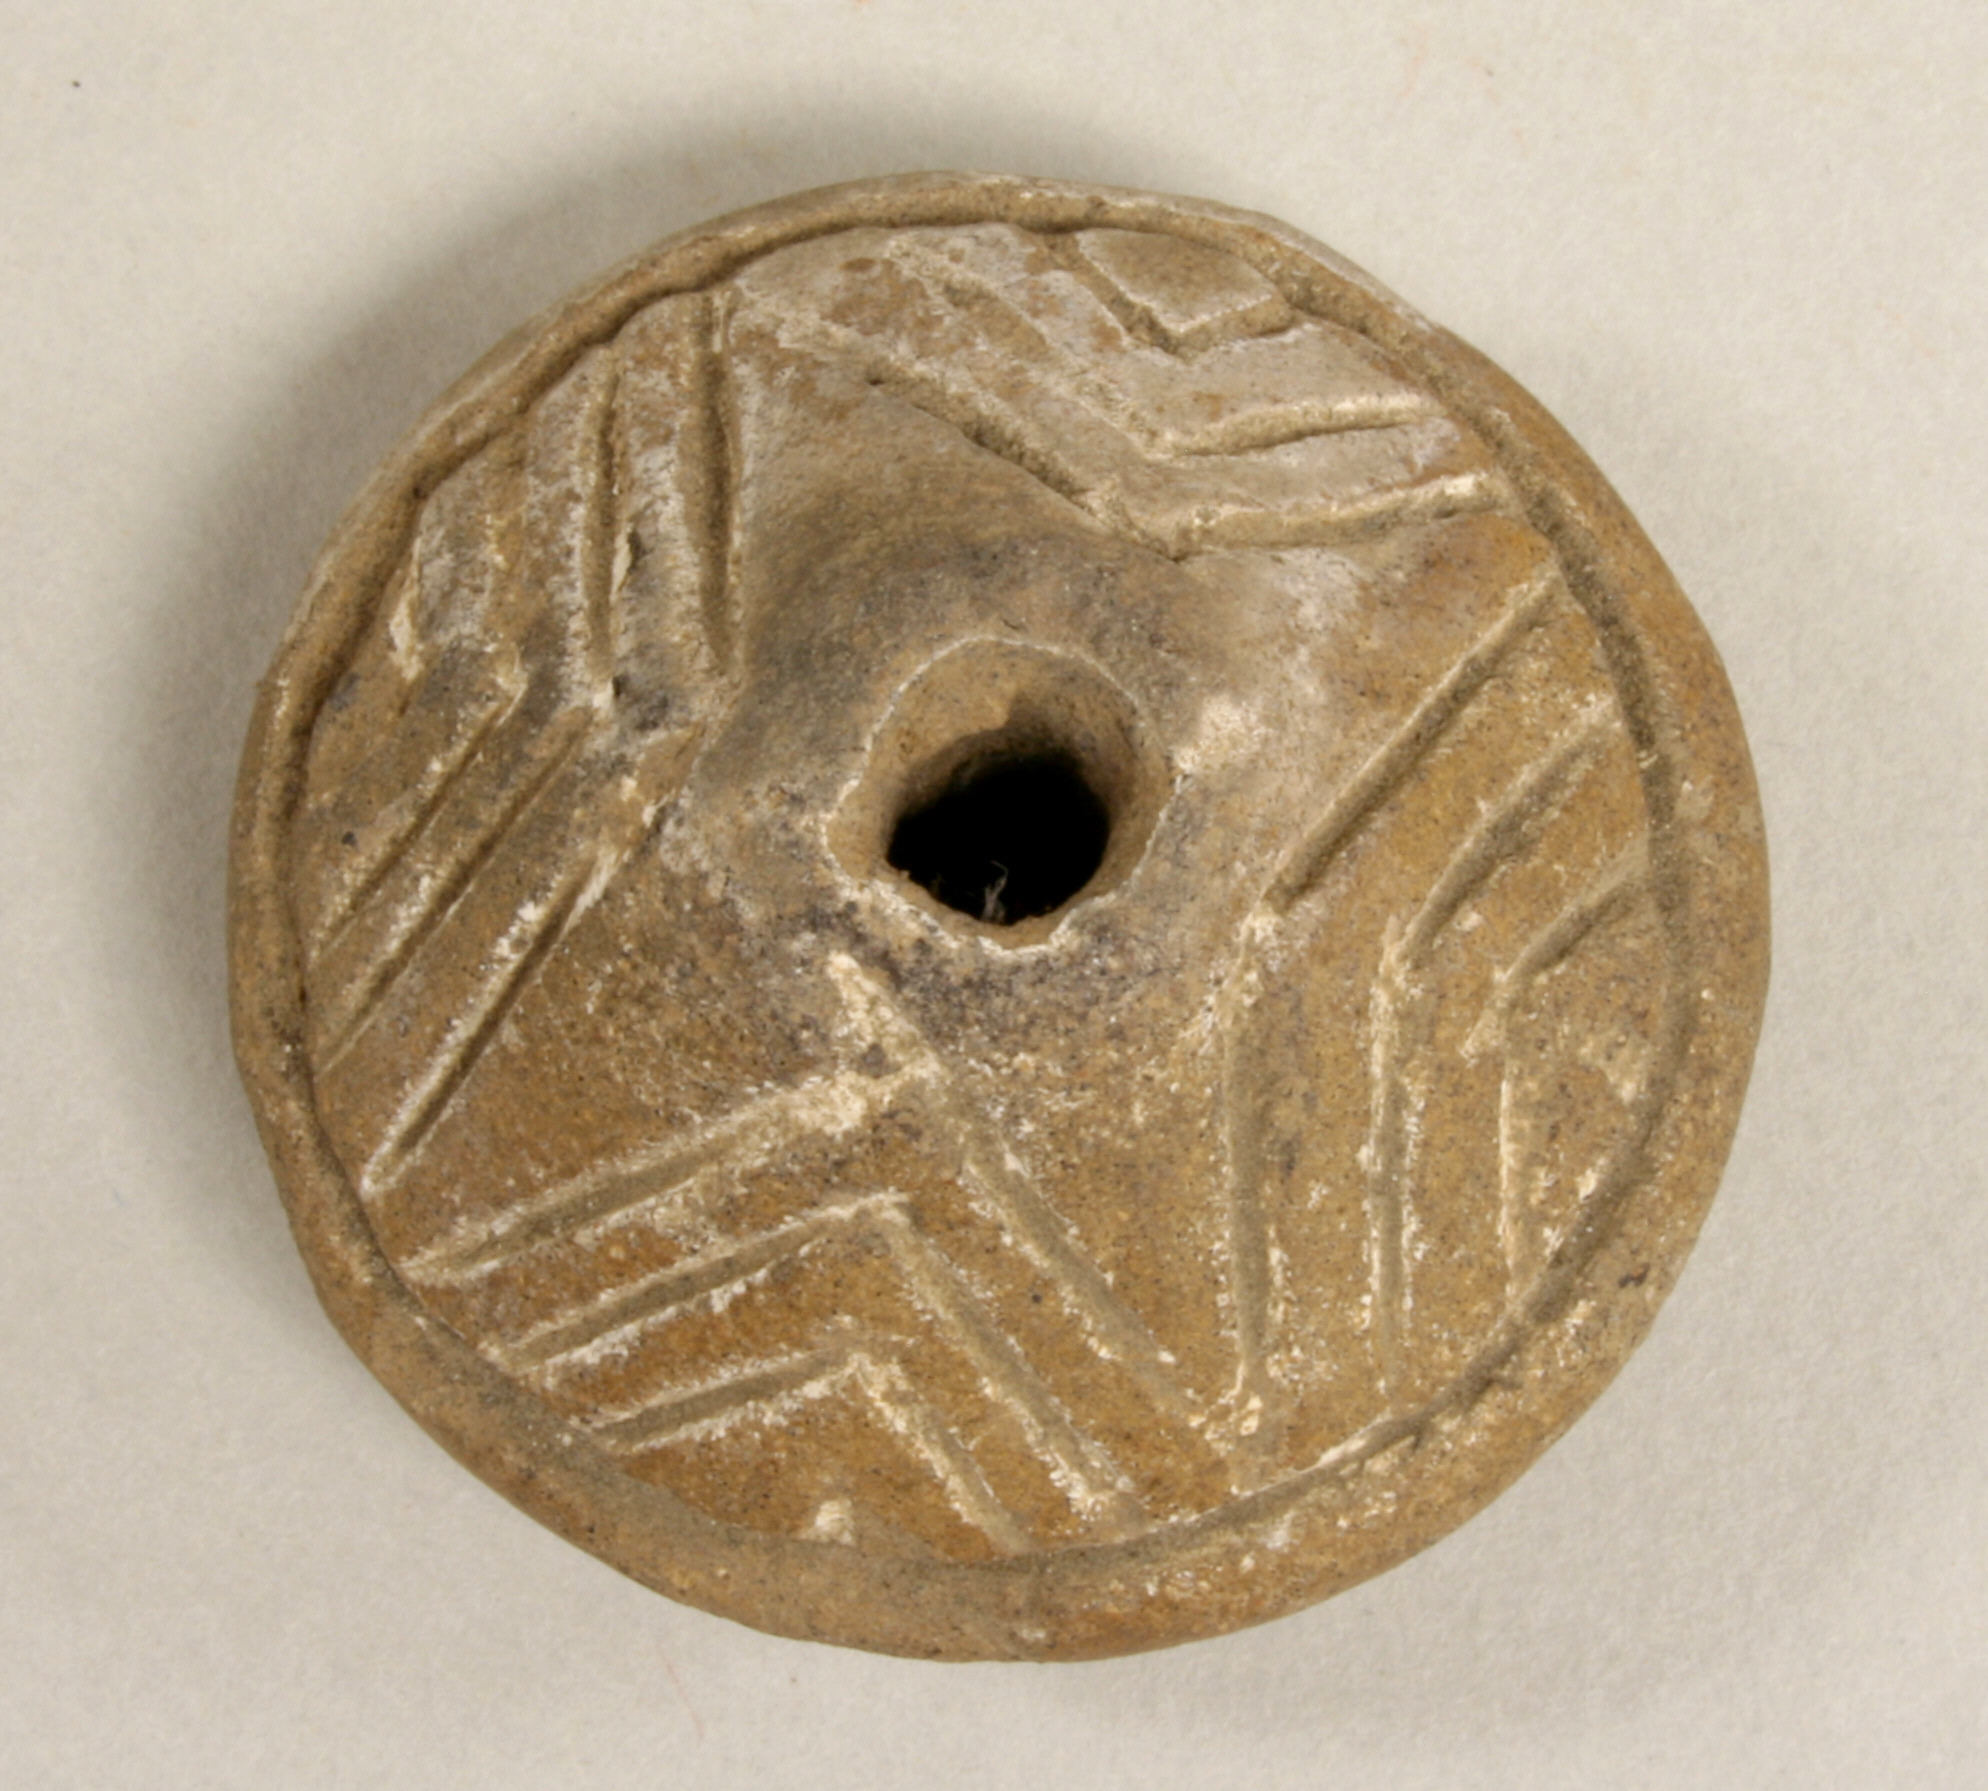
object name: spindle whorl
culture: mexican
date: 801-1500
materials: ceramic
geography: mexico